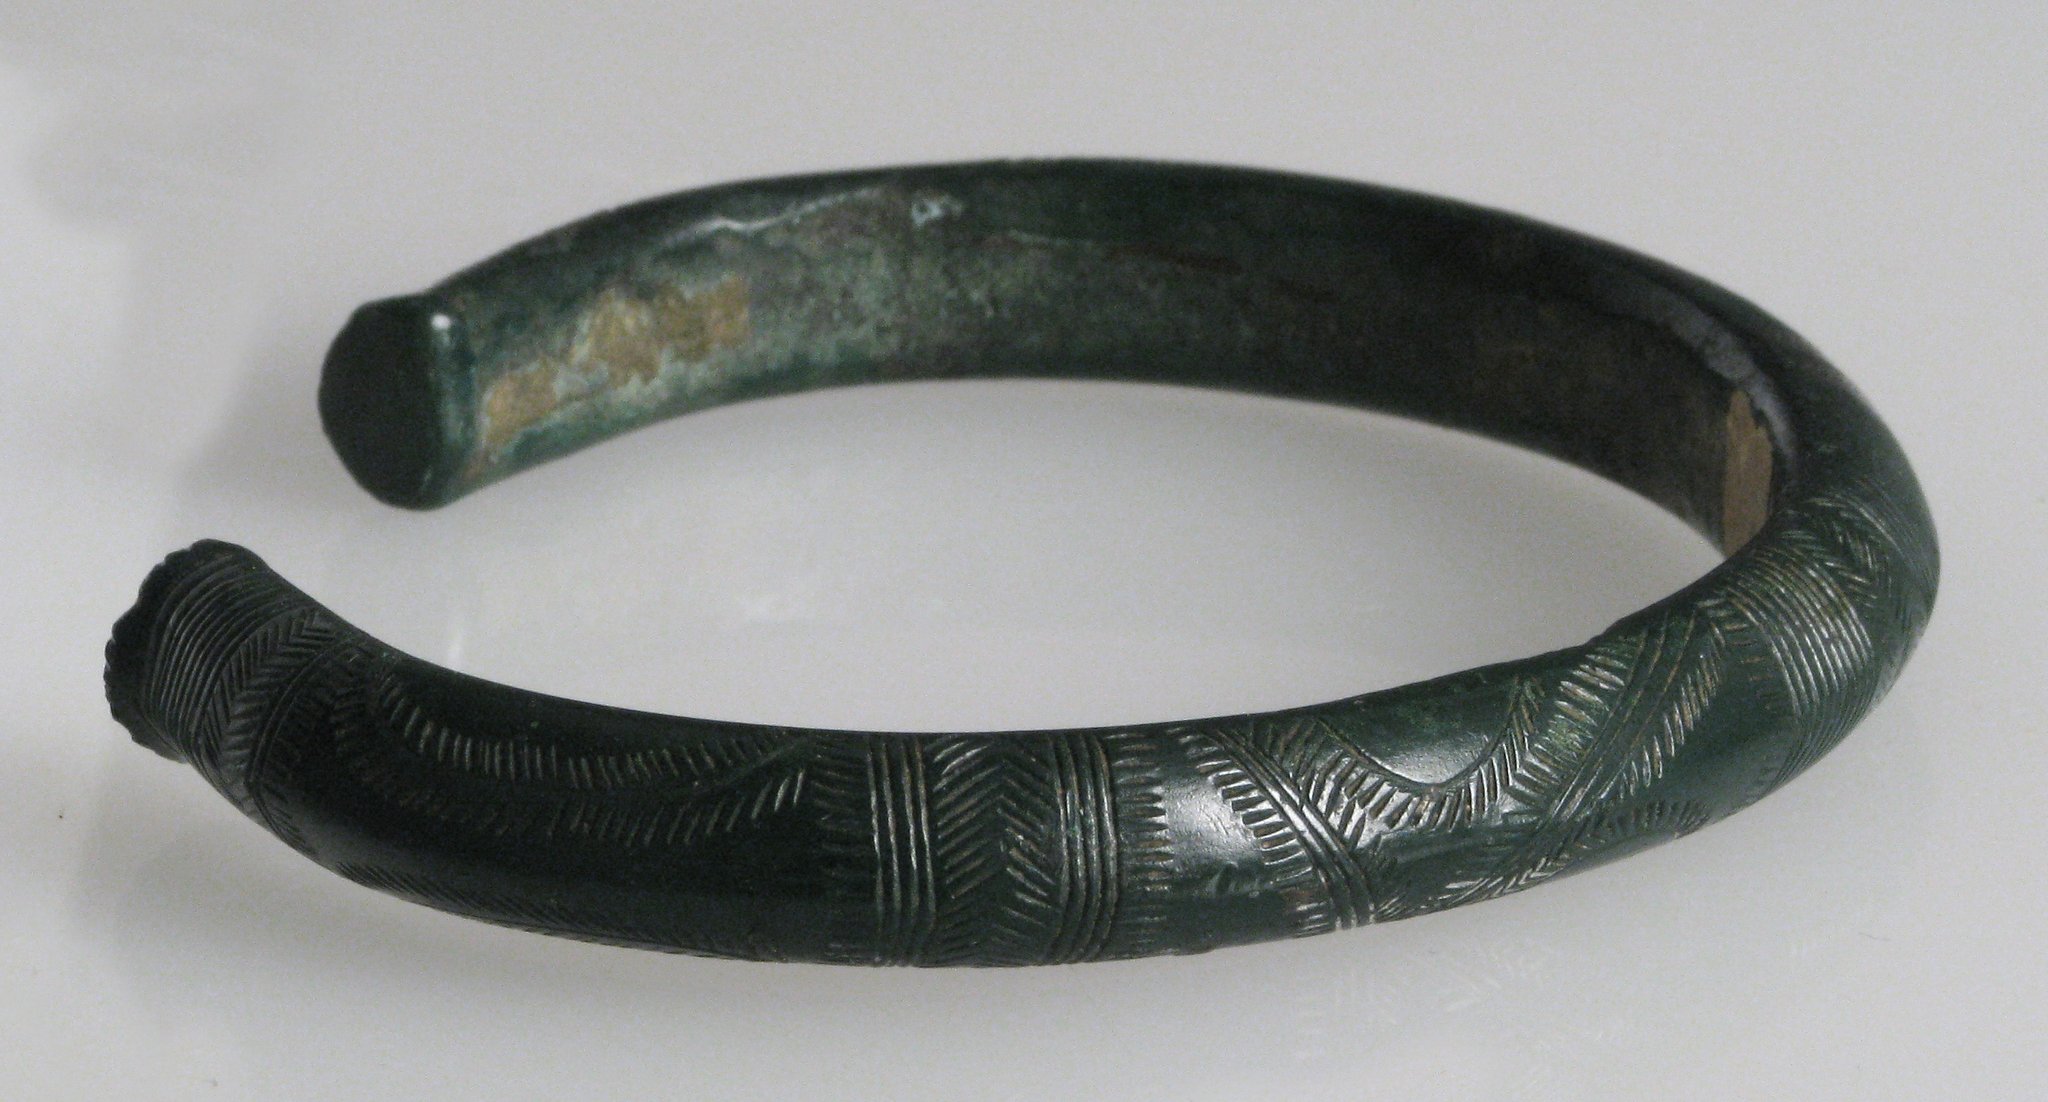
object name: bracelet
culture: hallstatt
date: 1200-800 BCE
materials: copper alloy